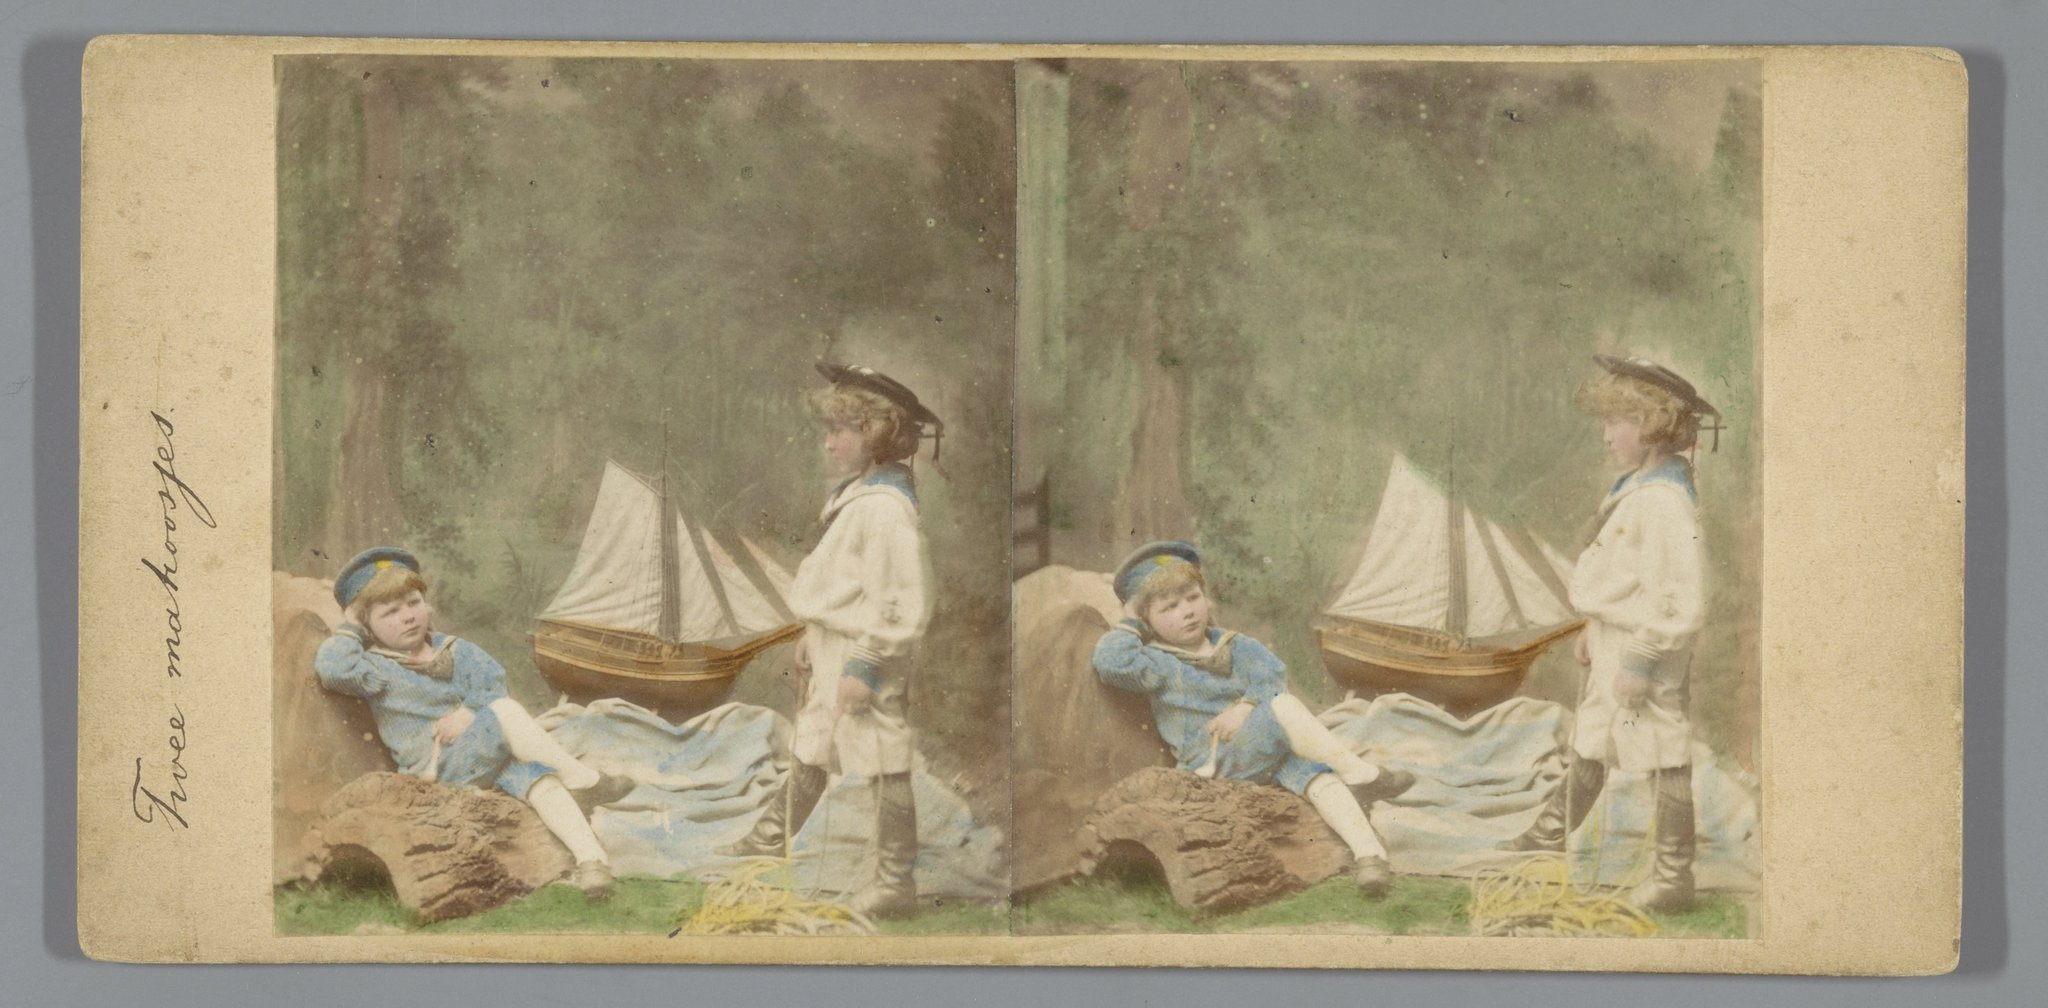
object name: stereograph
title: Twee matroosjes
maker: Anonymous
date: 1852-1863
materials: cardboard, paper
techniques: albumen print, hand coloring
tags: ensemble of pieces of clothing: sailor suit, trade games, imitative games, imitating adults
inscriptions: inscription: ‘60’